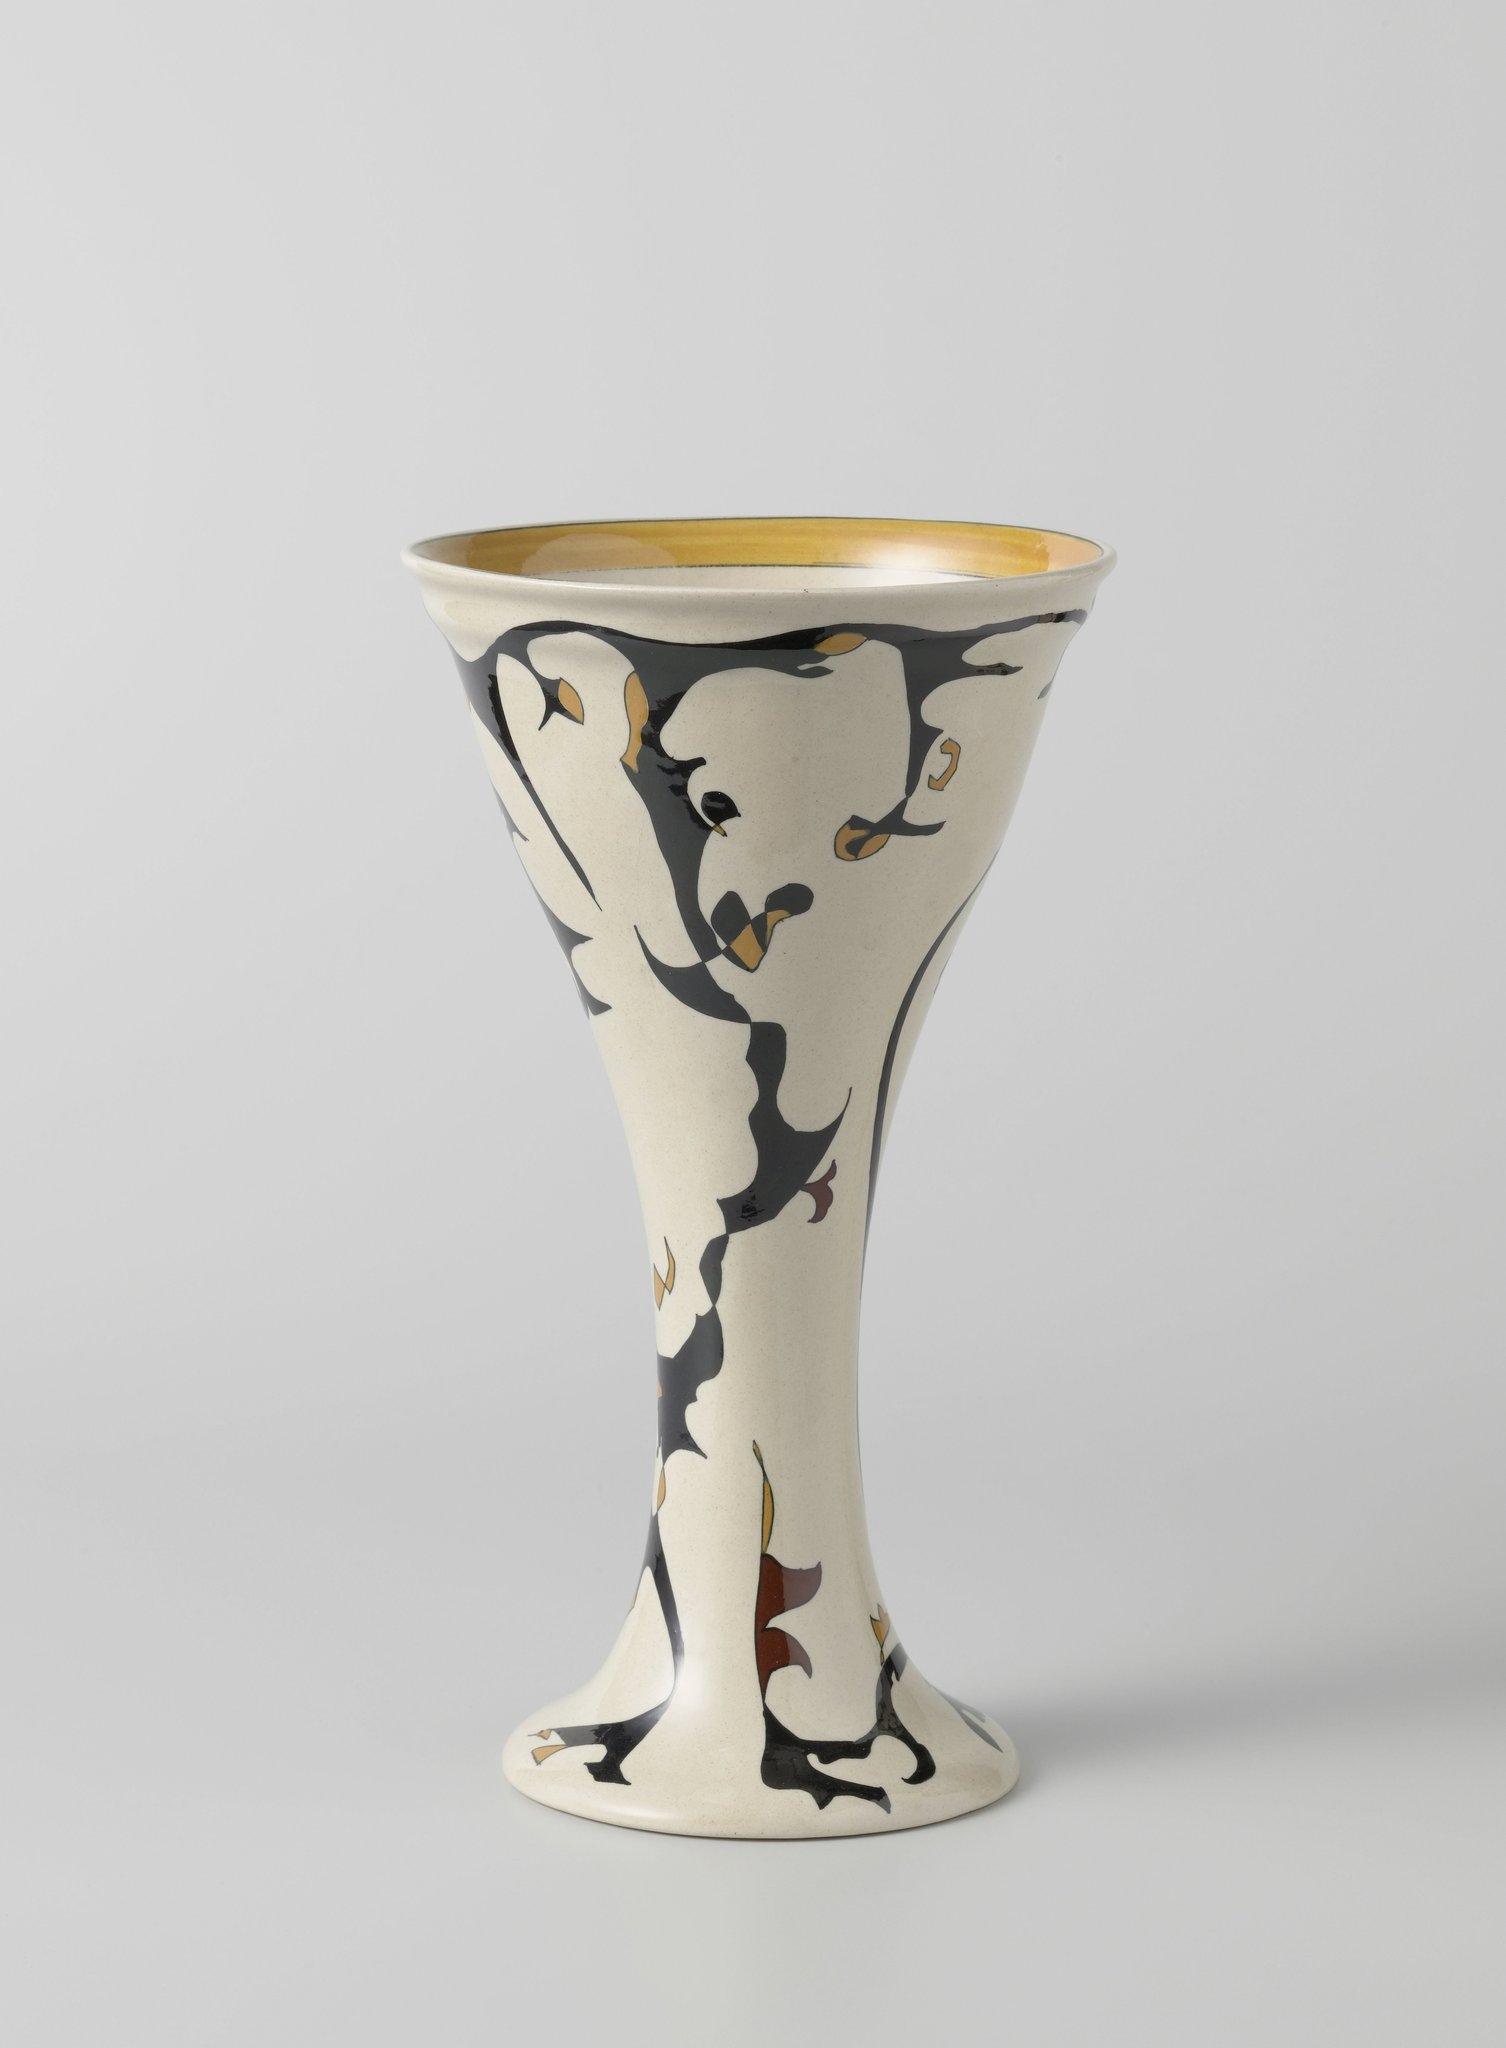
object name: tulip vase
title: Two tulip vases with the ‘Spichtig’ (Spindly) pattern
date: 1925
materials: earthenware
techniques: painted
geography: arnhem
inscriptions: mark: ‘fabrieksstempel in cirkelvorm, waaronder "Spichtig", 7/D, schildersmerk van Jo Blom (alles in zwart); ingegrift 4.’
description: Tulpenvaas van aardewerk, kelkvormig op ronde voet, polychroom beschilderd in de kleuren geelbruin, zwart en bruin met het decor "Spichtig". De binnenmondrand heeft een brede gele bies tussen zwarte lijnen. Gemerkt met fabrieksstempel in cirkelvorm, waaronder "Spichtig", 7/D, schildersmerk van Jo Blom (alles in zwart); ingegrift 4.